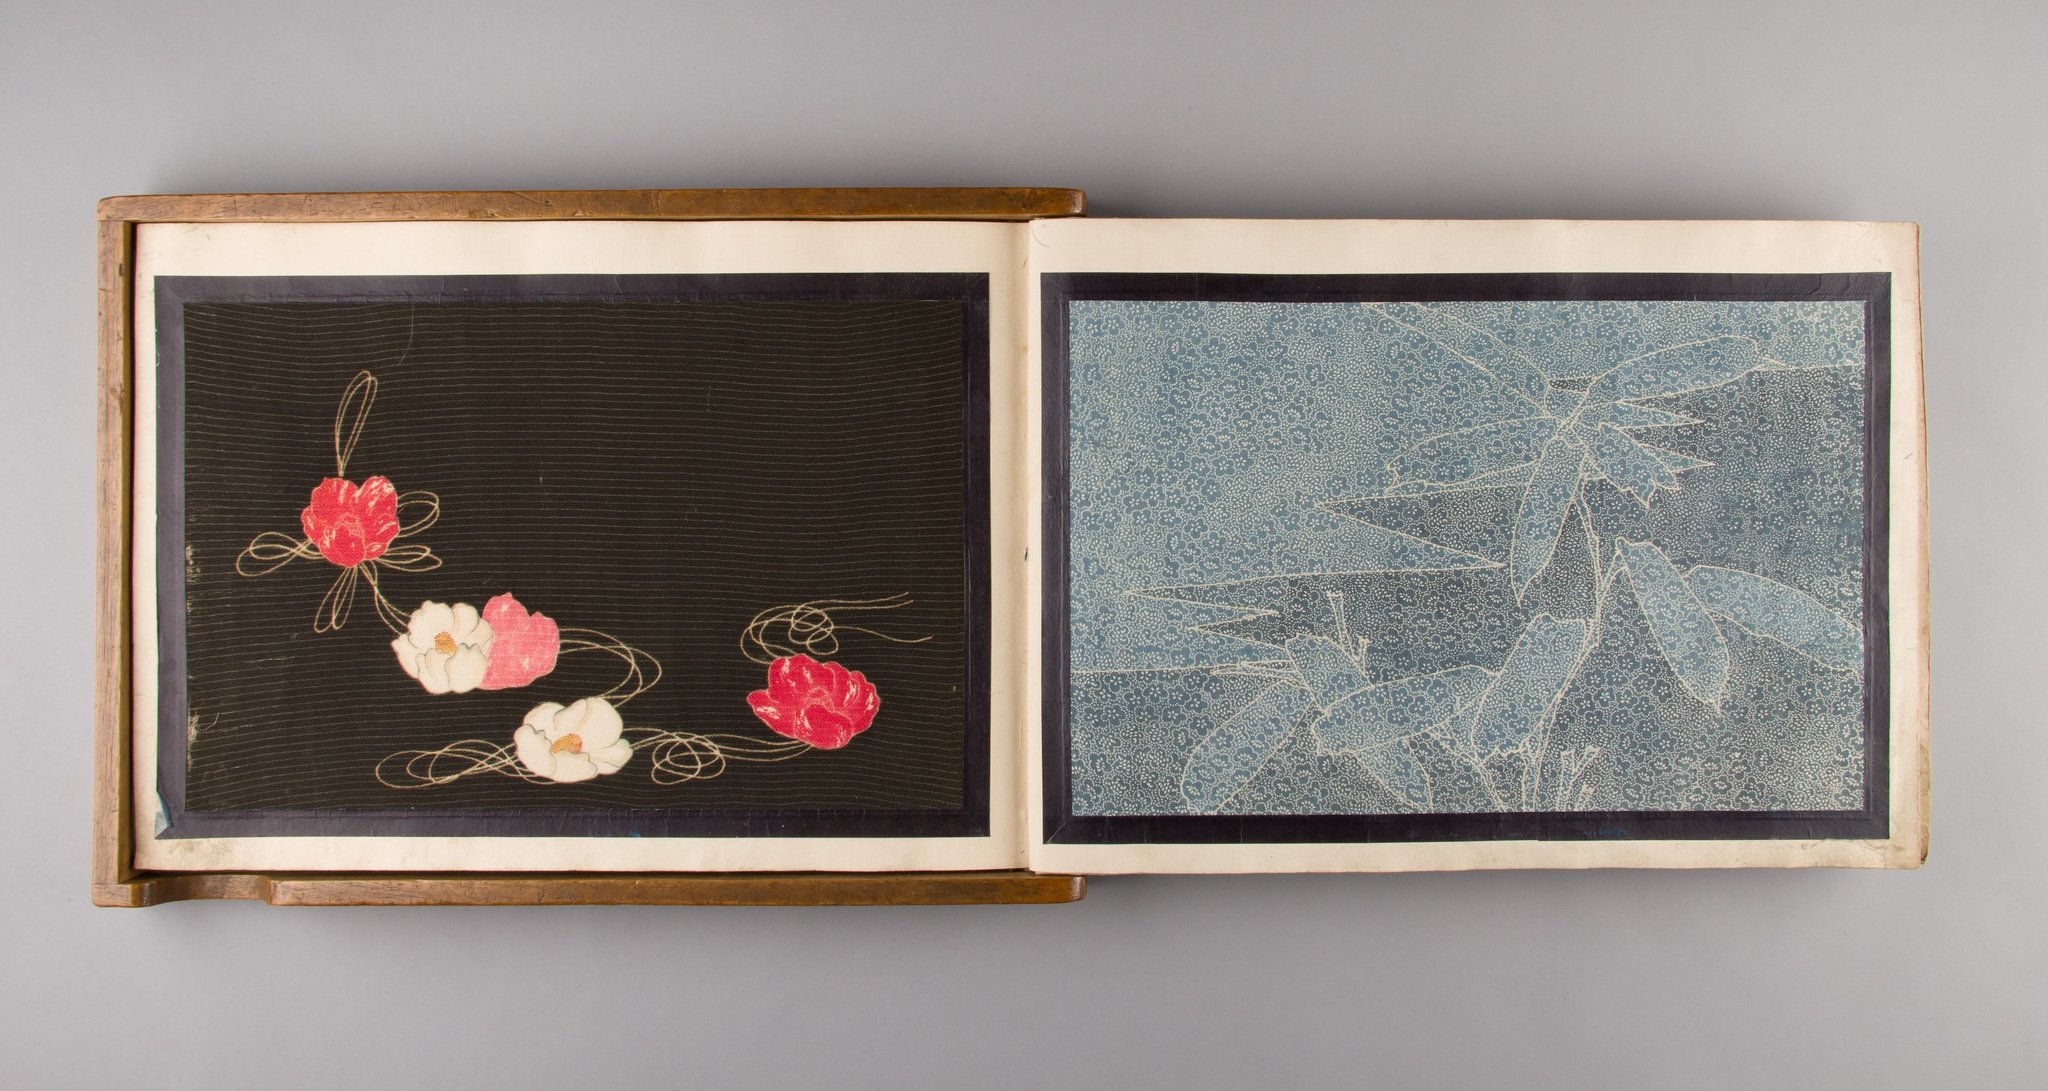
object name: album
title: Textile Pattern Sample Book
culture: japanese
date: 1834-1866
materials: textile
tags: flowers